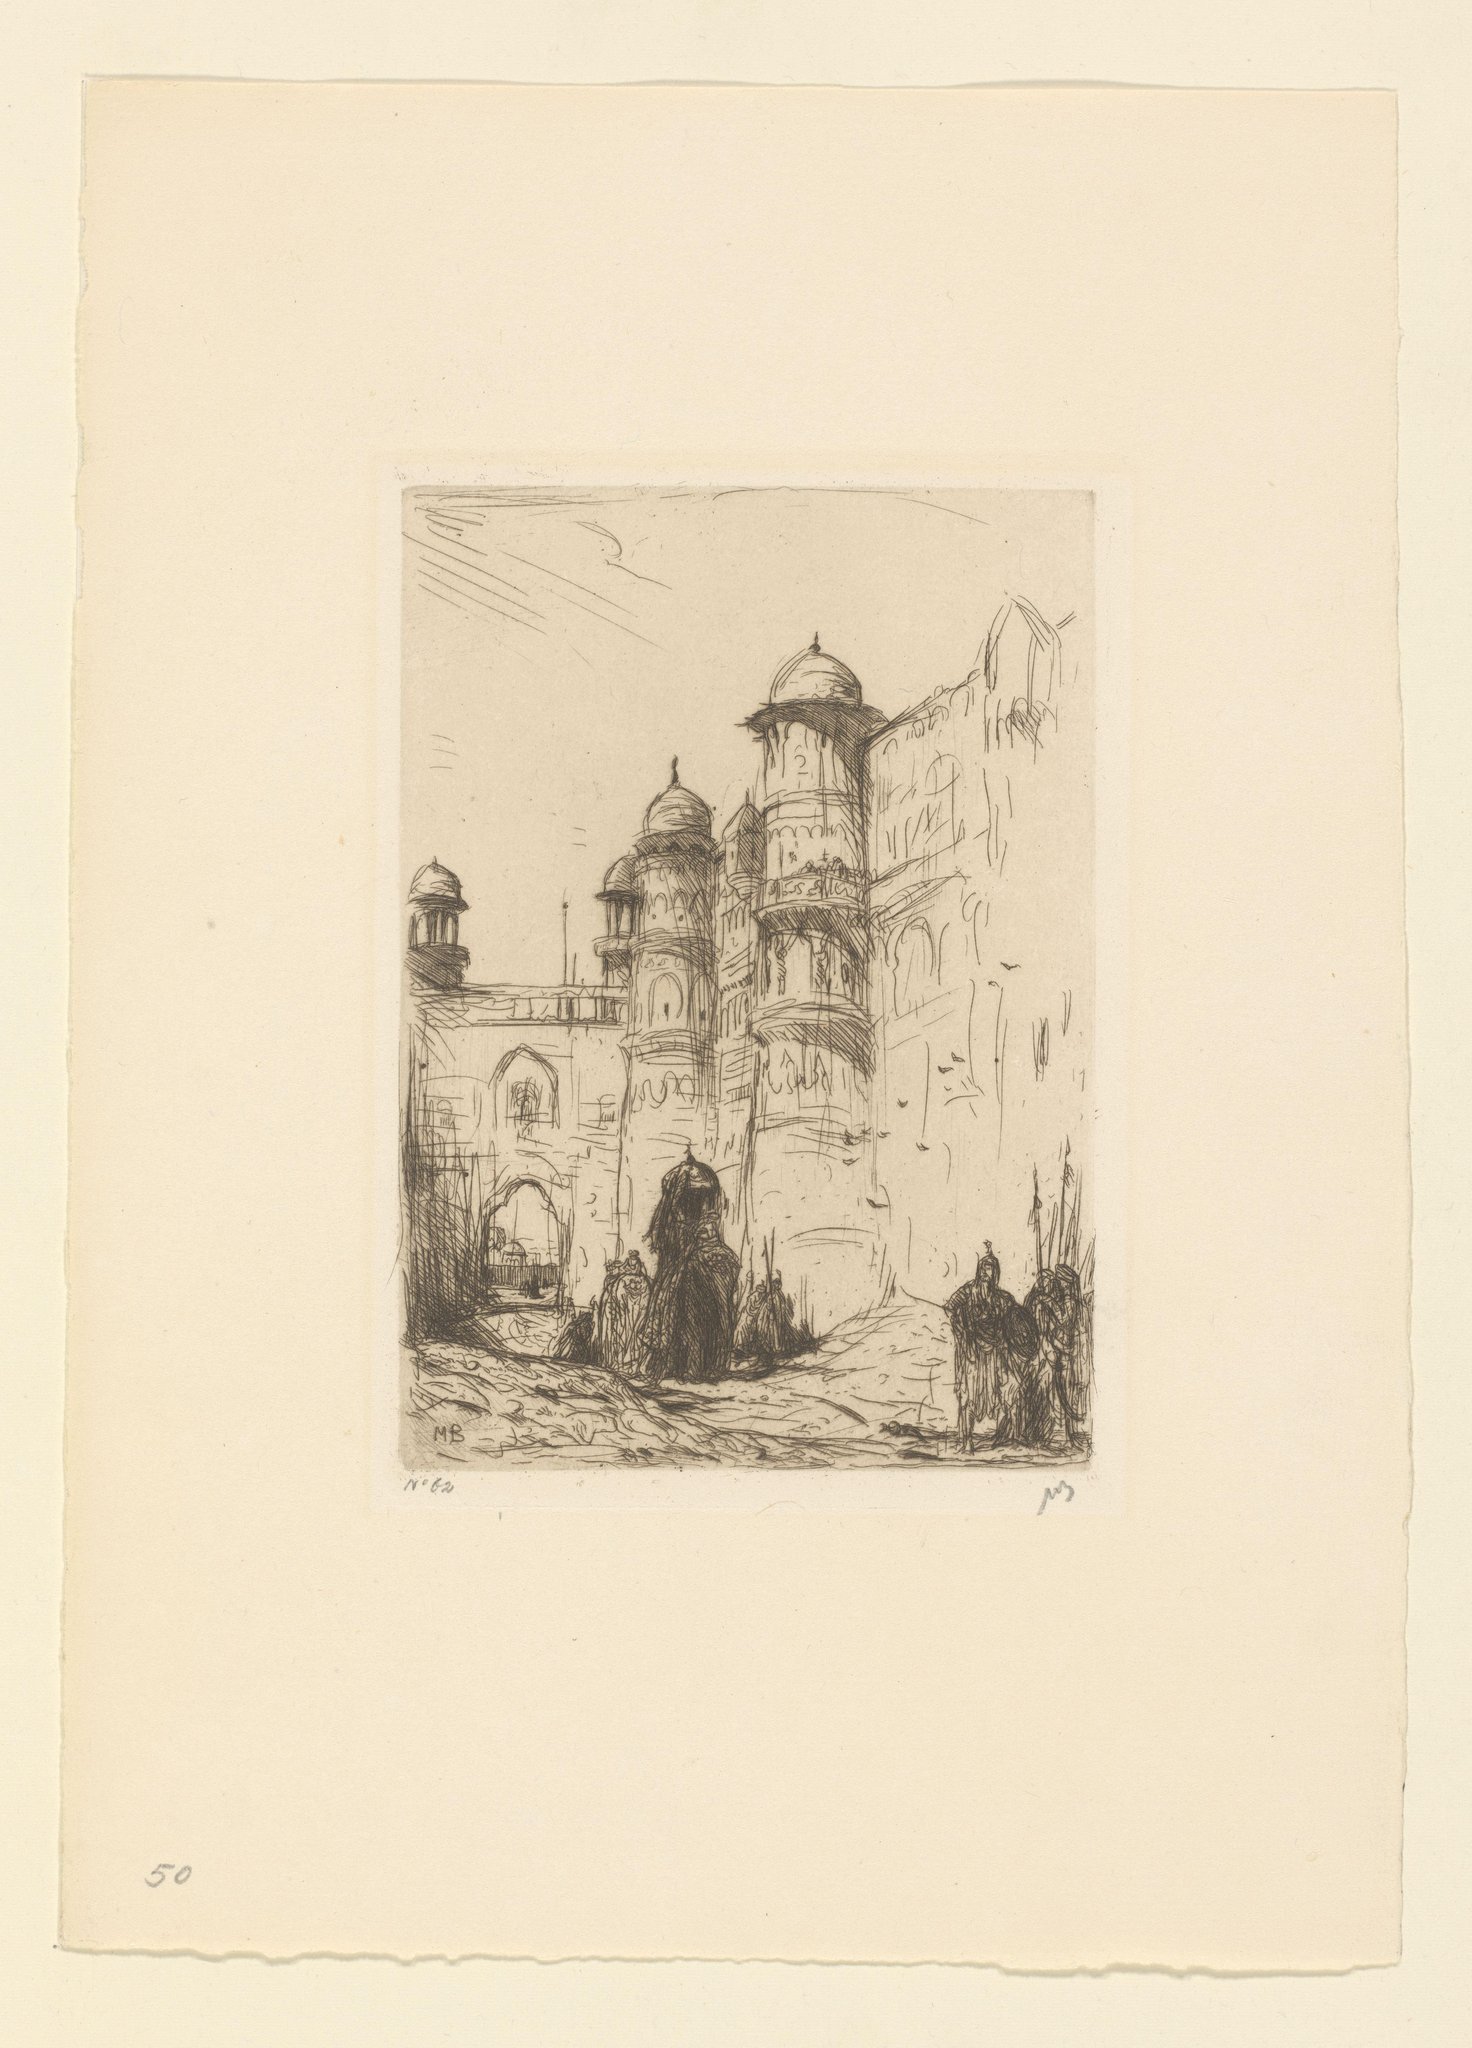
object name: print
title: Fort van Gwalior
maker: marius bauer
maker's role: draughtsman, print maker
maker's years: 1867-1932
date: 1898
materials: paper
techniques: etching, intaglio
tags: fortress, riding on animal other than horse, ass, or mule, trunked animals: elephant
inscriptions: collector's mark: Lugt 2228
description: De Olifantenpoort van het fort in Gwalior in Brits-Indië, zojuist gebruikt door twee olifanten die passagiers op hun rug vervoeren.